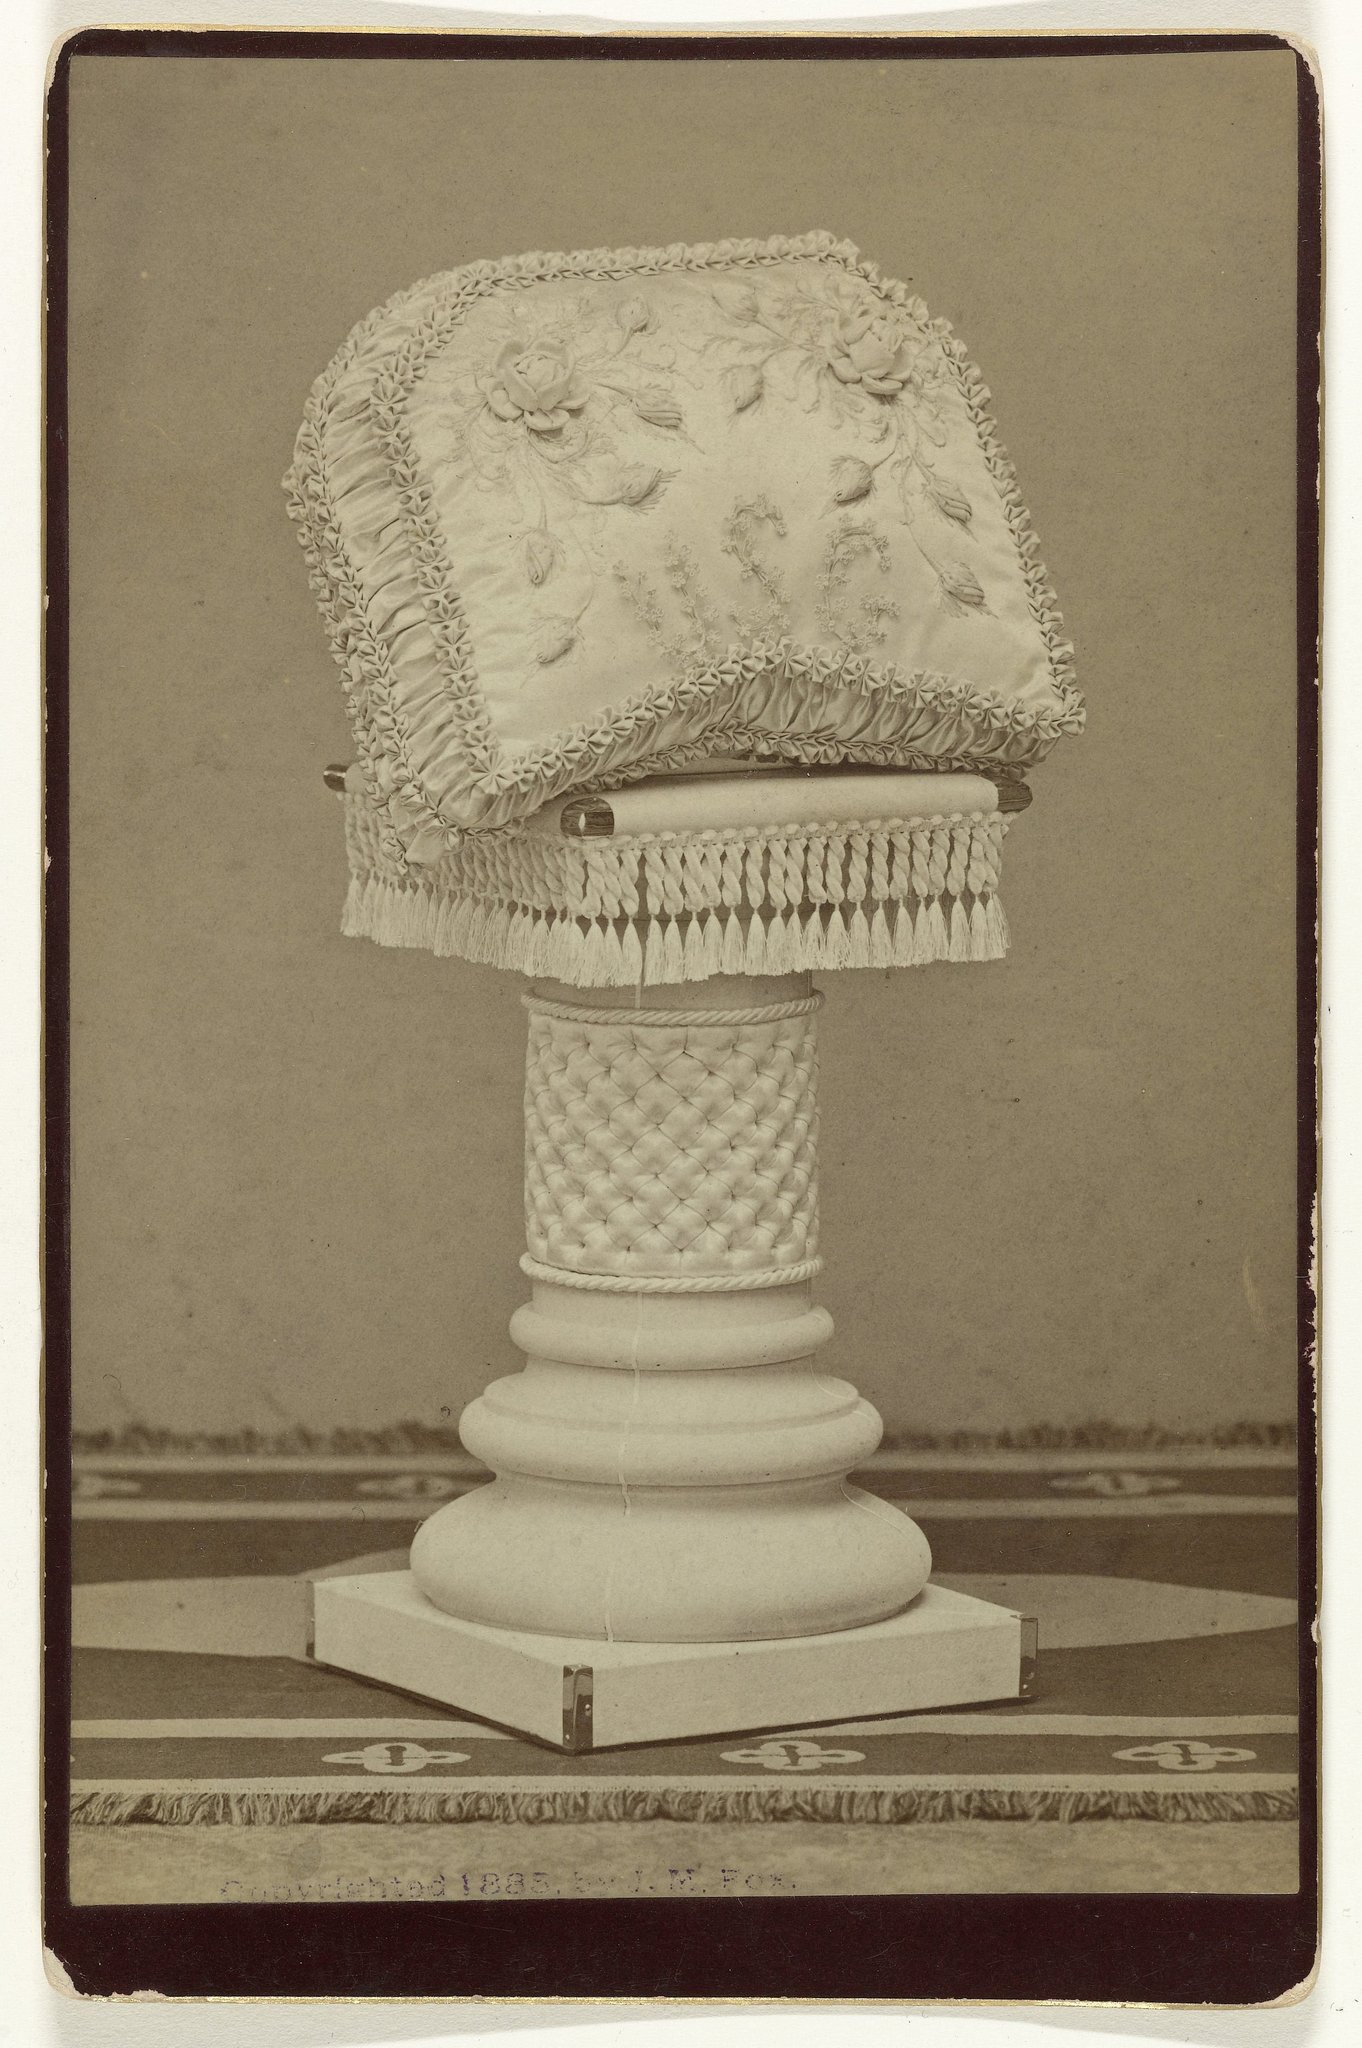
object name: cabinet photograph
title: Kussen gebruikt in de lijkkist van Ulysses S. Grant bij zijn begrafenis in 1885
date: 1885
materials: cardboard, paper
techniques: albumen print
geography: rochester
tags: funerary ceremonial, preparation of the corpse, mortuary toilet ~ burial, united states of america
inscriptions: annotation: ‘Copyrighted 1885 by J.M. Fox’, annotation: ‘“THE PILLOW” / used in the “Grant State Casket,” manufactured by the STEIN / MFG. Co., ROCHESTER, N. Y., was made out of the finest / light cream satin, circled with white rose trimming. The top / of the pillow is decorated with ribbon embroidered flowers, in / the form of a circle about the head, while in the center in for- / get-me-nots are the raised initials “U. S. G.” This pillow / is the most magnificent one ever made and has elicited many / words of praise. // We hereby certify that this photograph was taken from the original / pillow made by us and designed for the casket of the late Gen. Graut [sic]. / STEIN MANUFACTURING CO. // Sworn to before me this 20th day / of July, 1885. / S. L. DOBBIN, Com. Of Deeds. // J. M. FOX, PHOTOGRAPHER.’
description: Kussen gebruikt in de lijkkist (‘Grant State Casket’) van Ulysses S. Grant bij zijn begrafenis in 1885, Verenigde Staten, vervaardigd door Stein Manufacturing Company, Rochester, NY. Kussen gefotografeerd op pilaar.